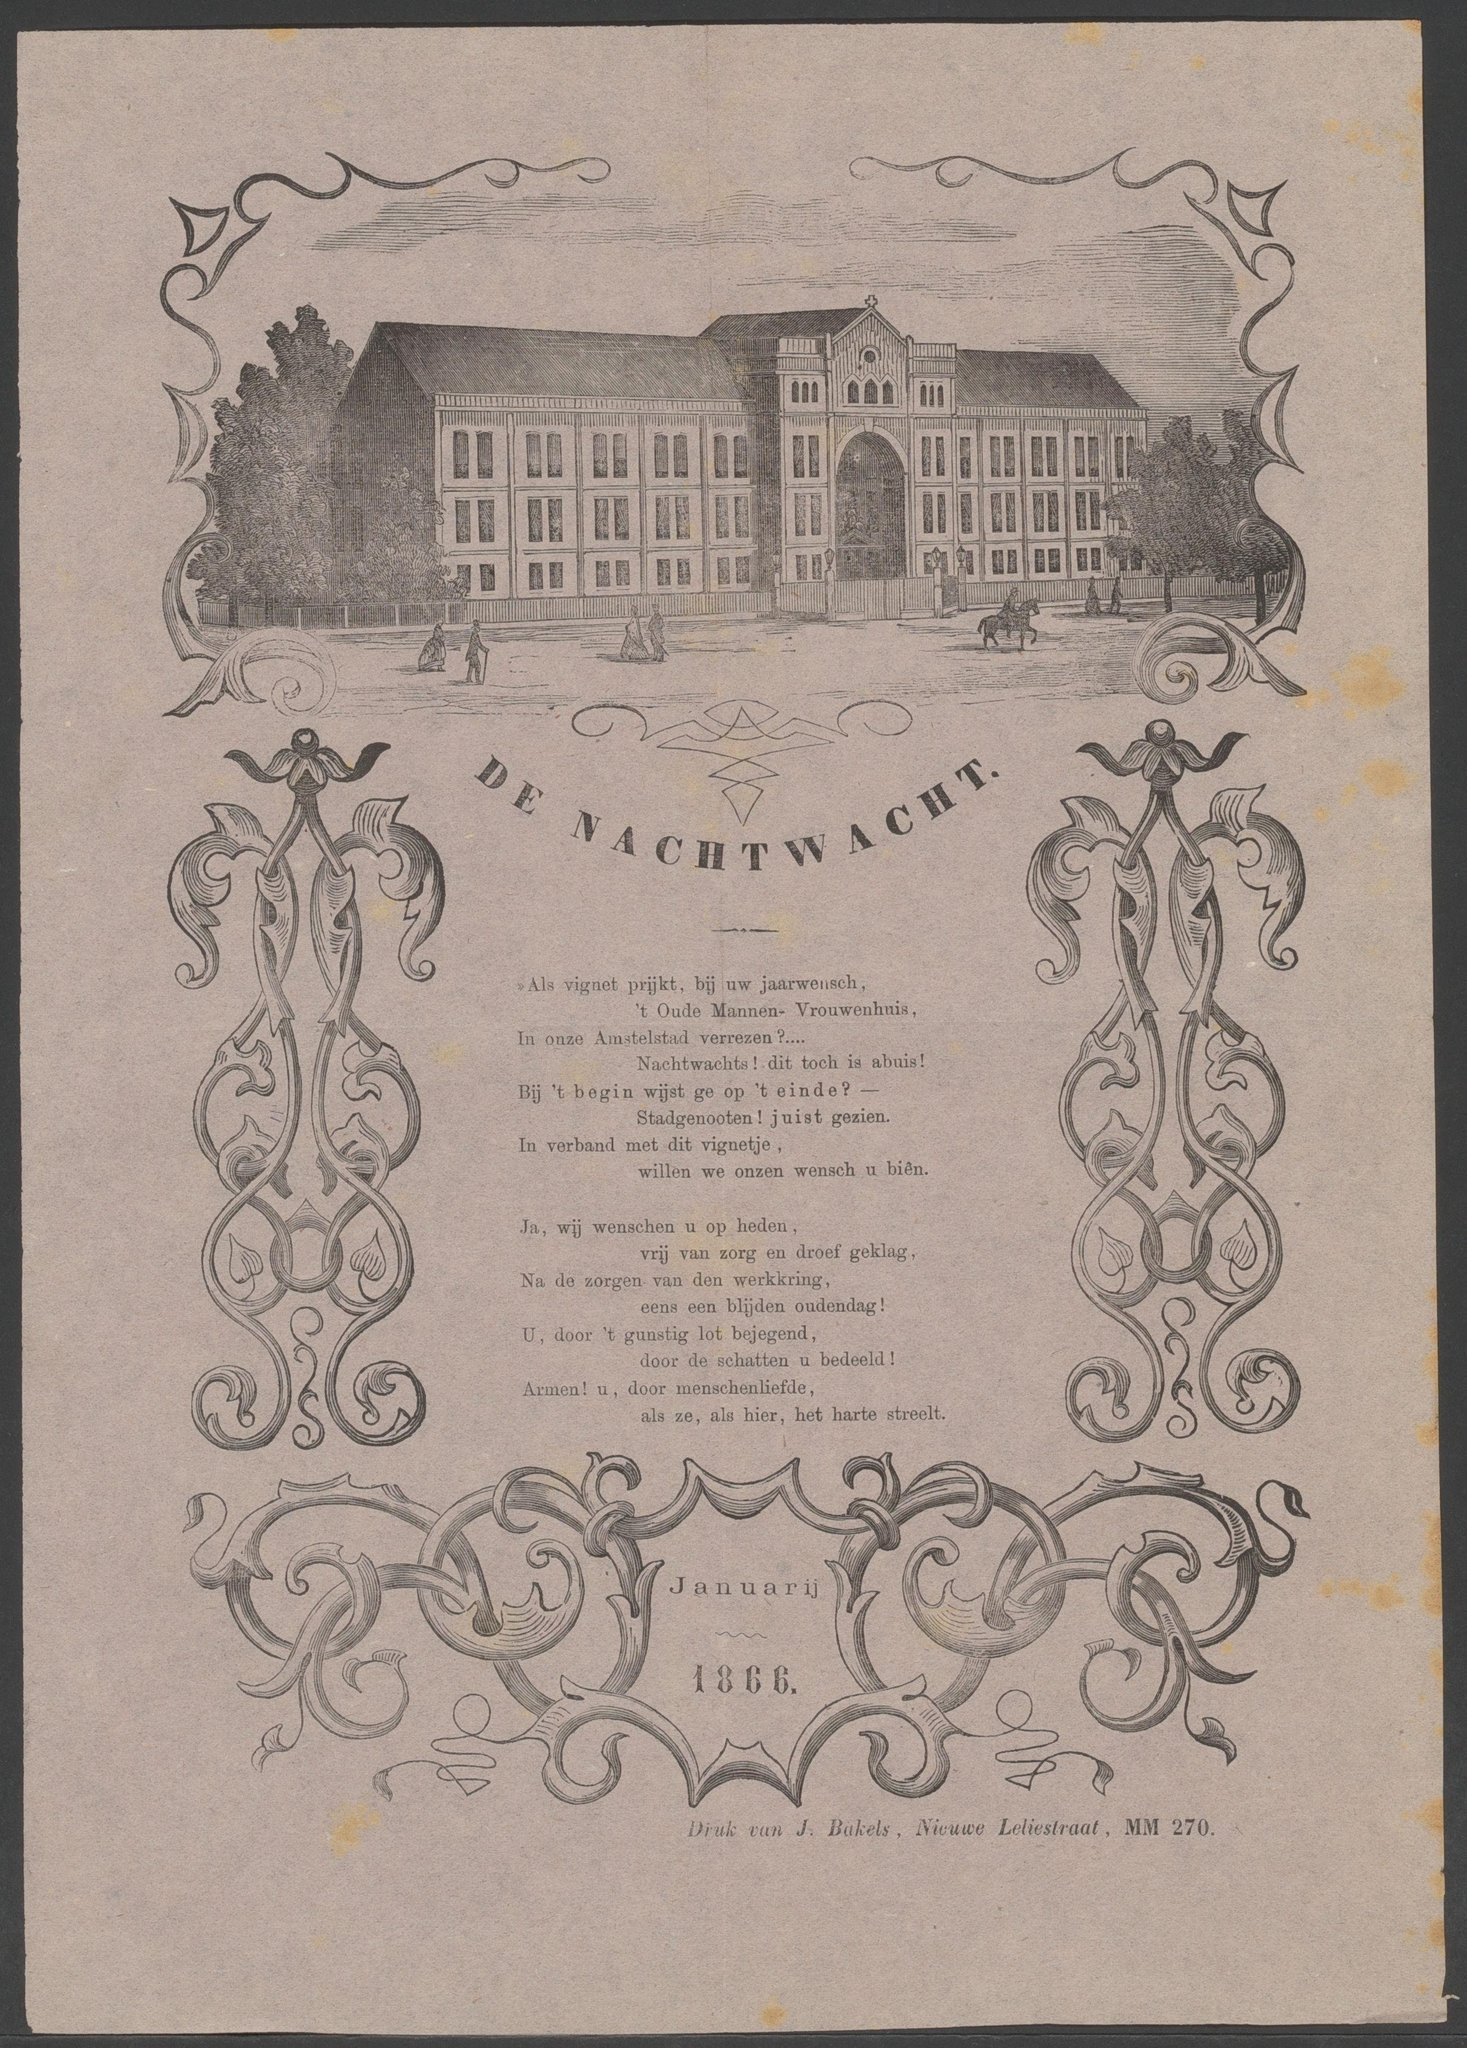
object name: new year card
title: De Nachtwacht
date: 1865-1866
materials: paper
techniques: letterpress printing, engraving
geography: amsterdam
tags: night patrol, care of the aged, civic architecture; edifices; dwellings, amsterdam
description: Nieuwjaarswens van de Amsterdamse nachtwacht (ratelwacht), 1866. Centraal een gedicht, daarboven een gezicht op het Oudemannenhuis. Om het gedicht een decoratieve lijst met organische vormen. Onderwerpsrubrieken binnen de Atlas Zeden en Gewoonten: Zeden en gewoonten in engeren zin, Volksleven, Volksbladen, Nieuwjaars- en Kerstwenschen, Amsterdam.